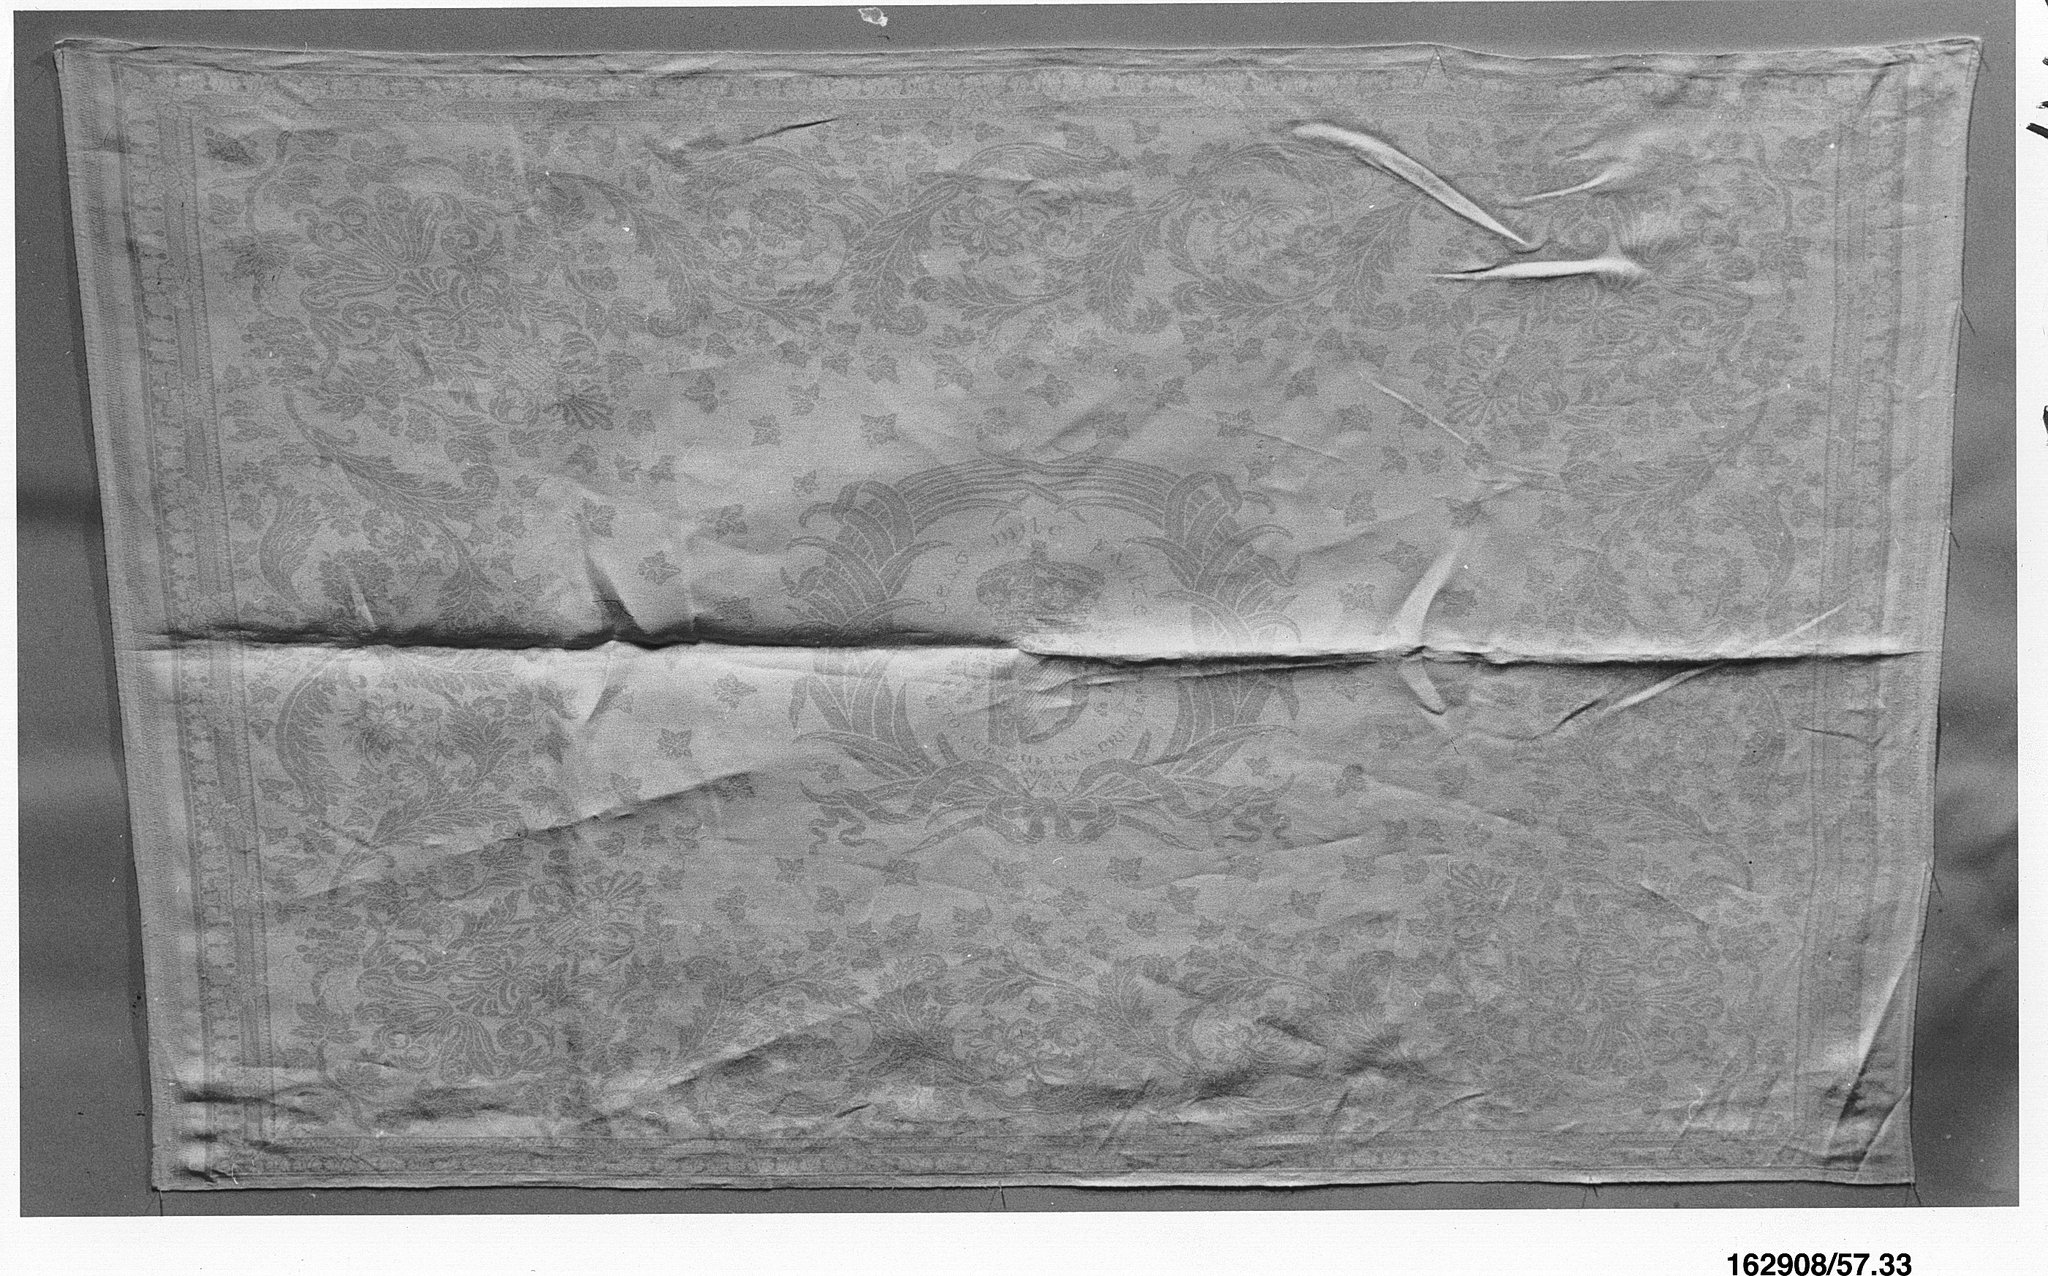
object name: napkin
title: Dinner napkin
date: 1849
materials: linen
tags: flowers